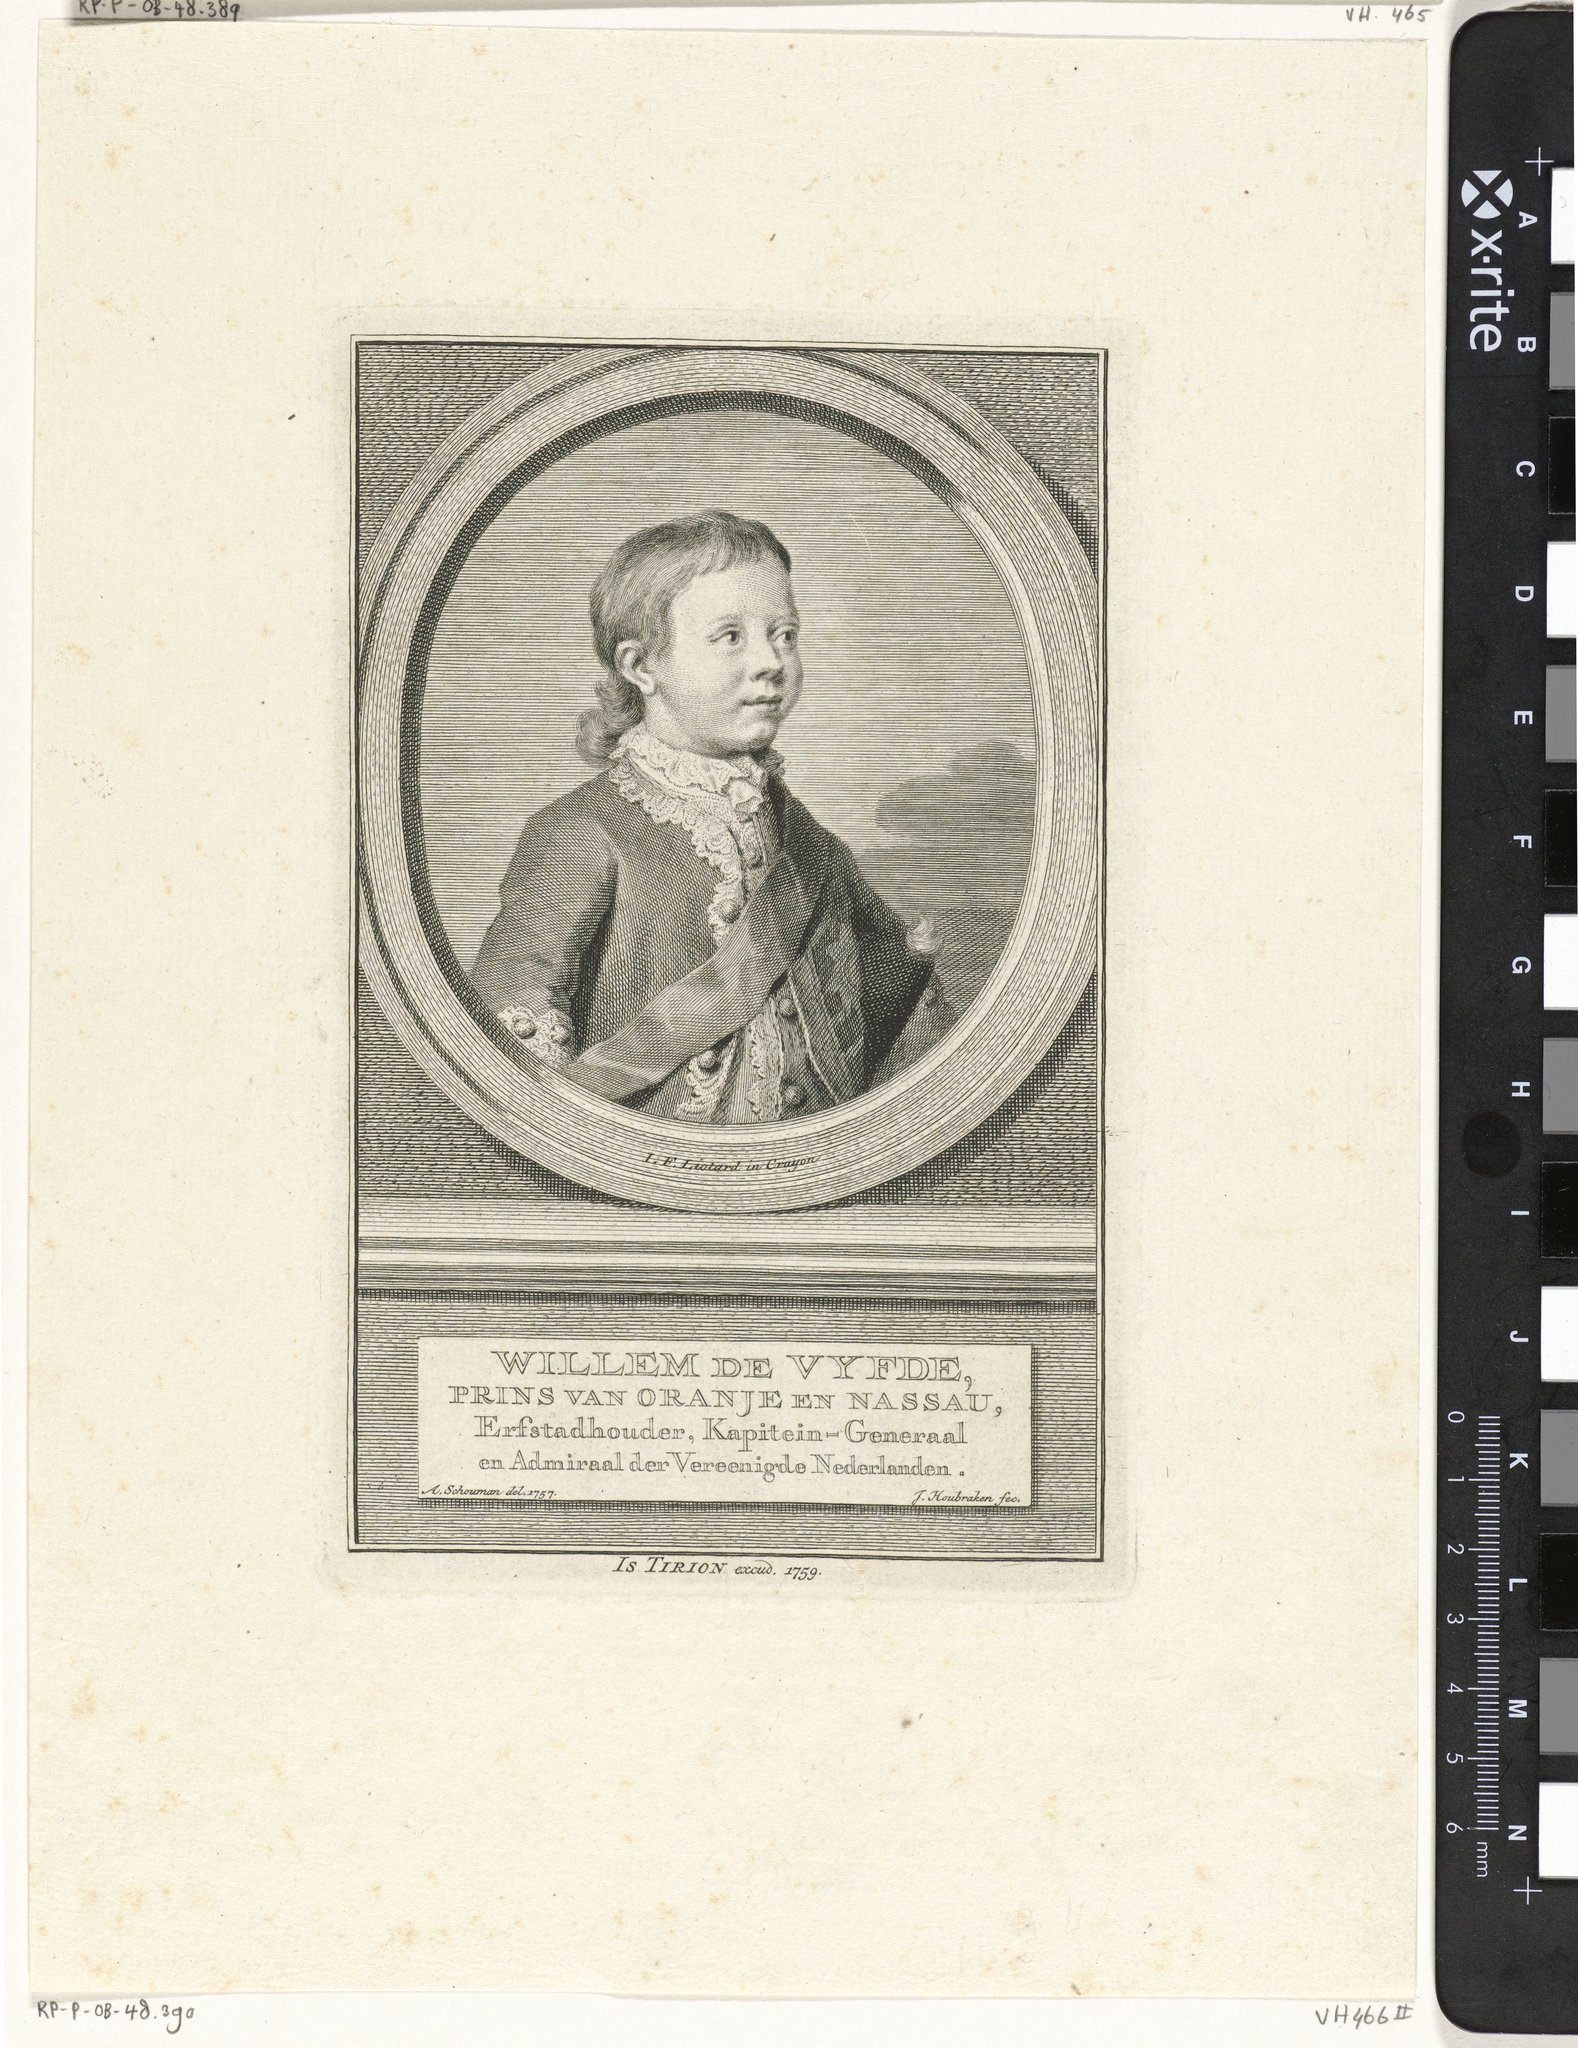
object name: print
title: Portret van Willem V, prins van Oranje-Nassau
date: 1759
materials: paper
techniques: engraving, etching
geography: amsterdam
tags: the hague, william v (prince of orange)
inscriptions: collector's mark: Lugt 2228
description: Prent ook gebruikt in: Jan Wagenaar, Vaderlandsche historie, vervattende de geschiedenissen der nu Vereenigde Nederlanden, inzonderheid die van Holland (...), 21 delen. Amsterdam, Isaak Tirion, 1749-59.